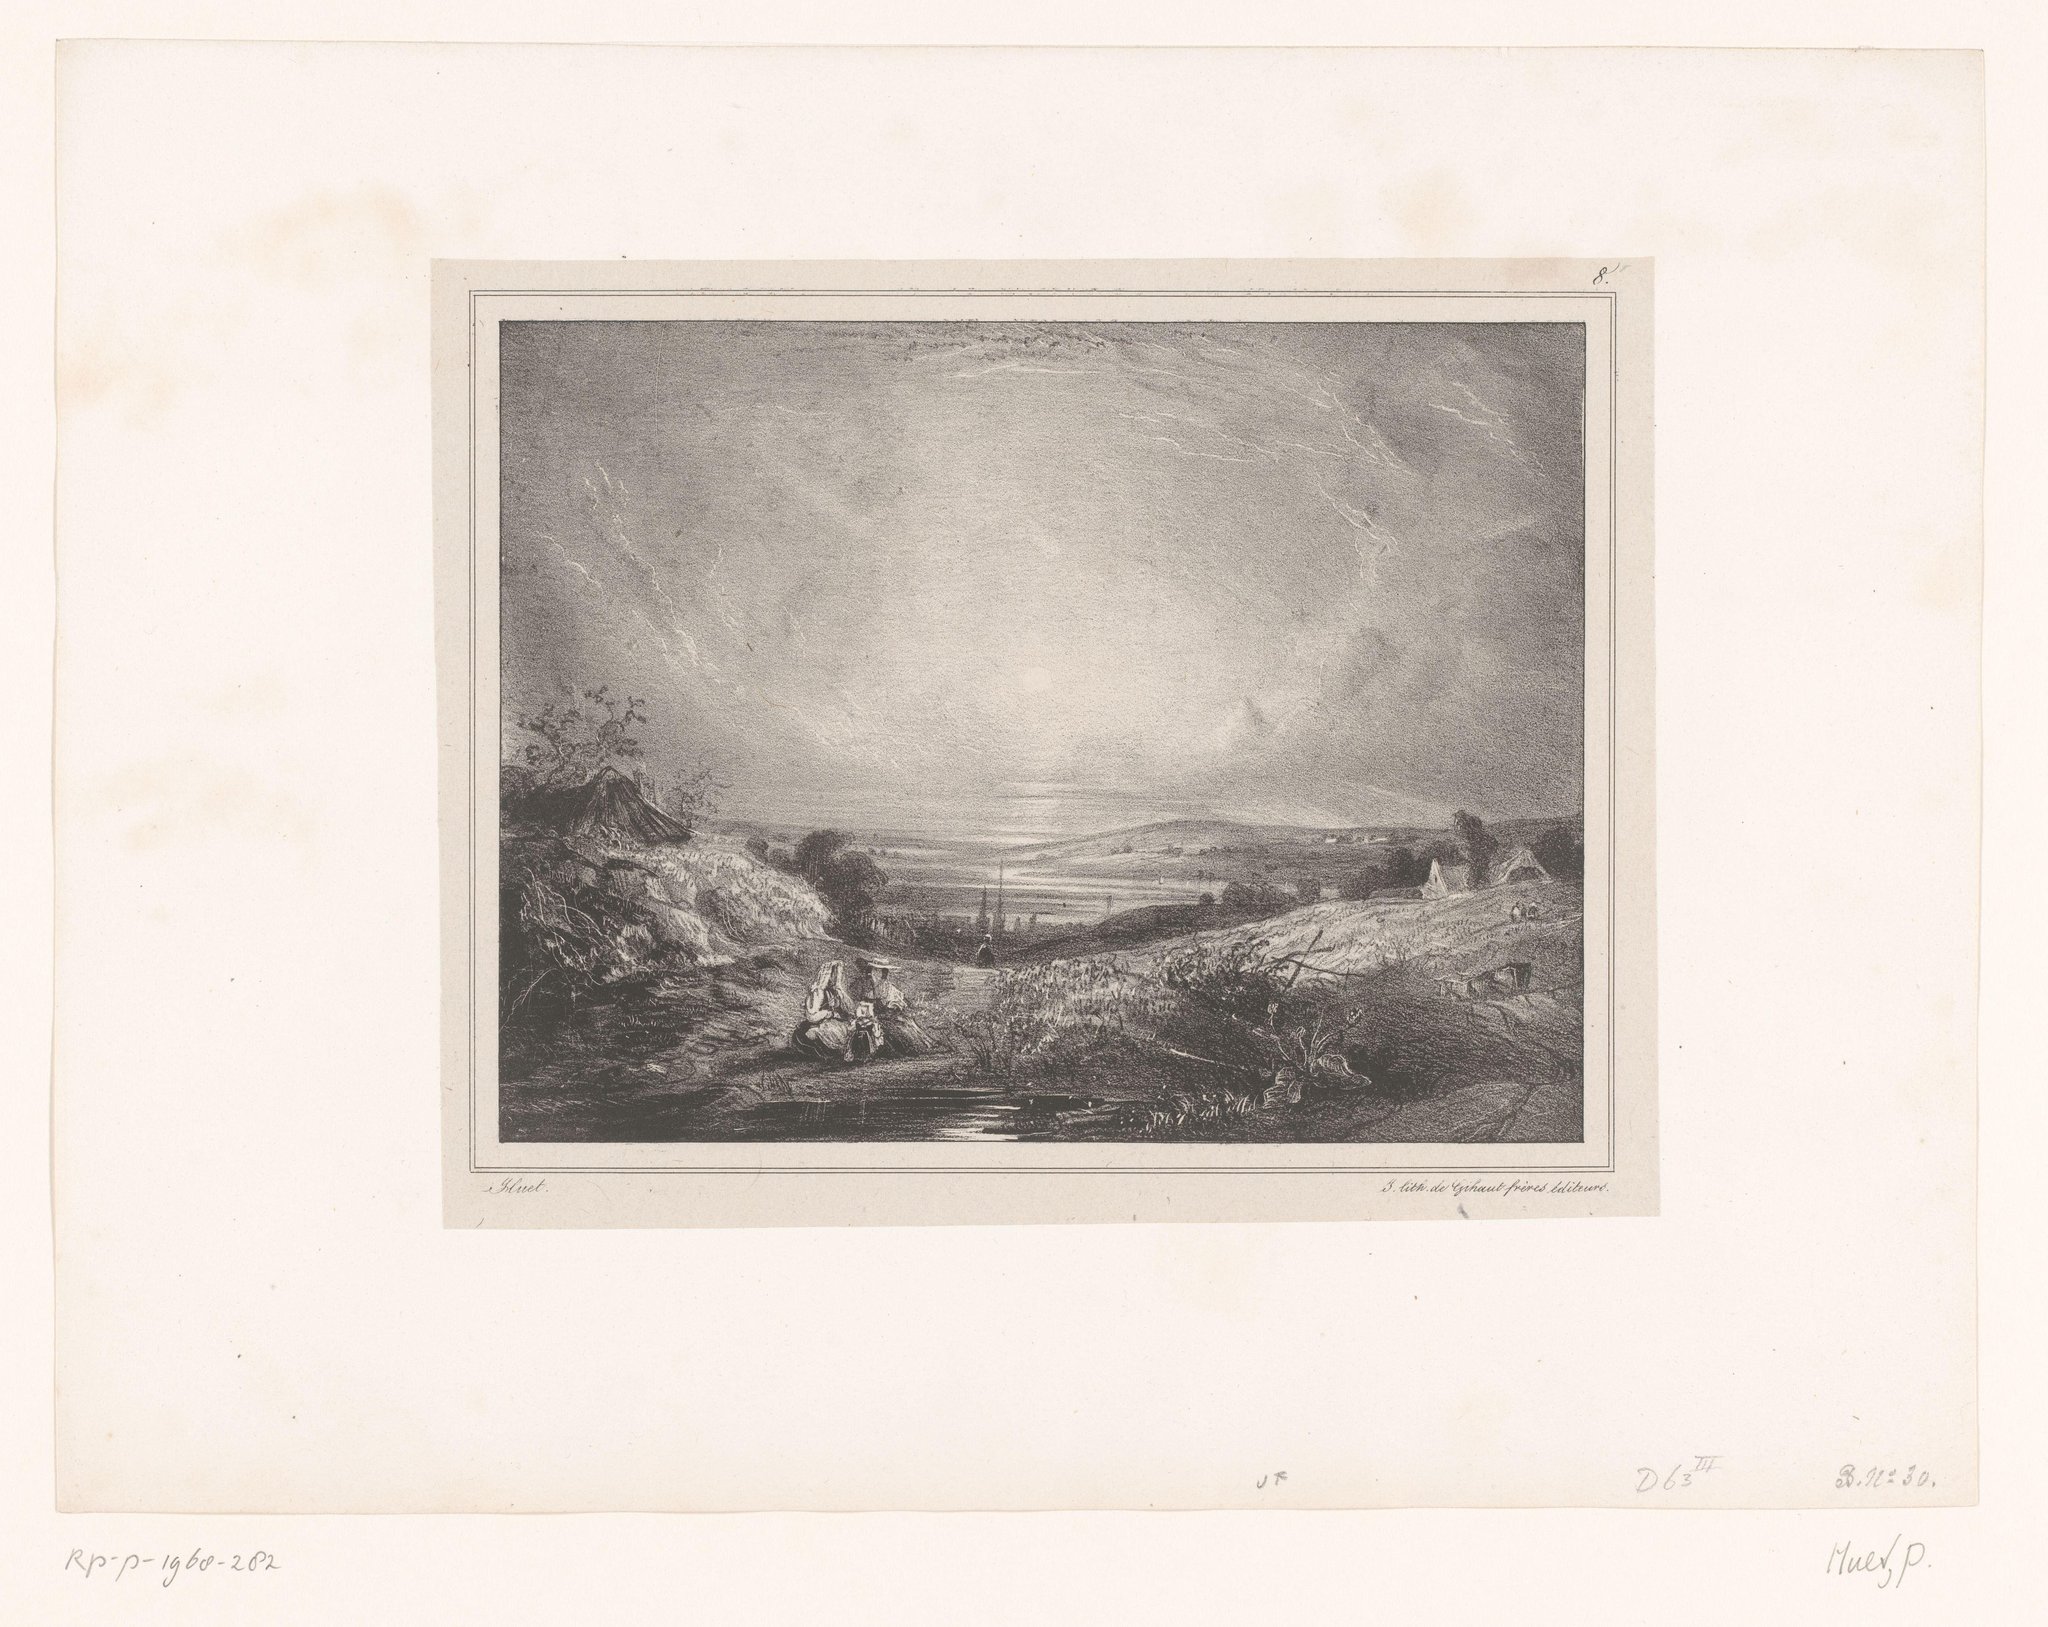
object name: print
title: Landschap met zicht op Rouen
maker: paul huet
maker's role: draughtsman, print maker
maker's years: 1803-1869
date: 1831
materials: paper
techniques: lithograph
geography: paris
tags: sunlight, city-view in general; 'veduta' (+ city(-scape) with figures, staffage)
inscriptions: collector's mark: Lugt 2228a